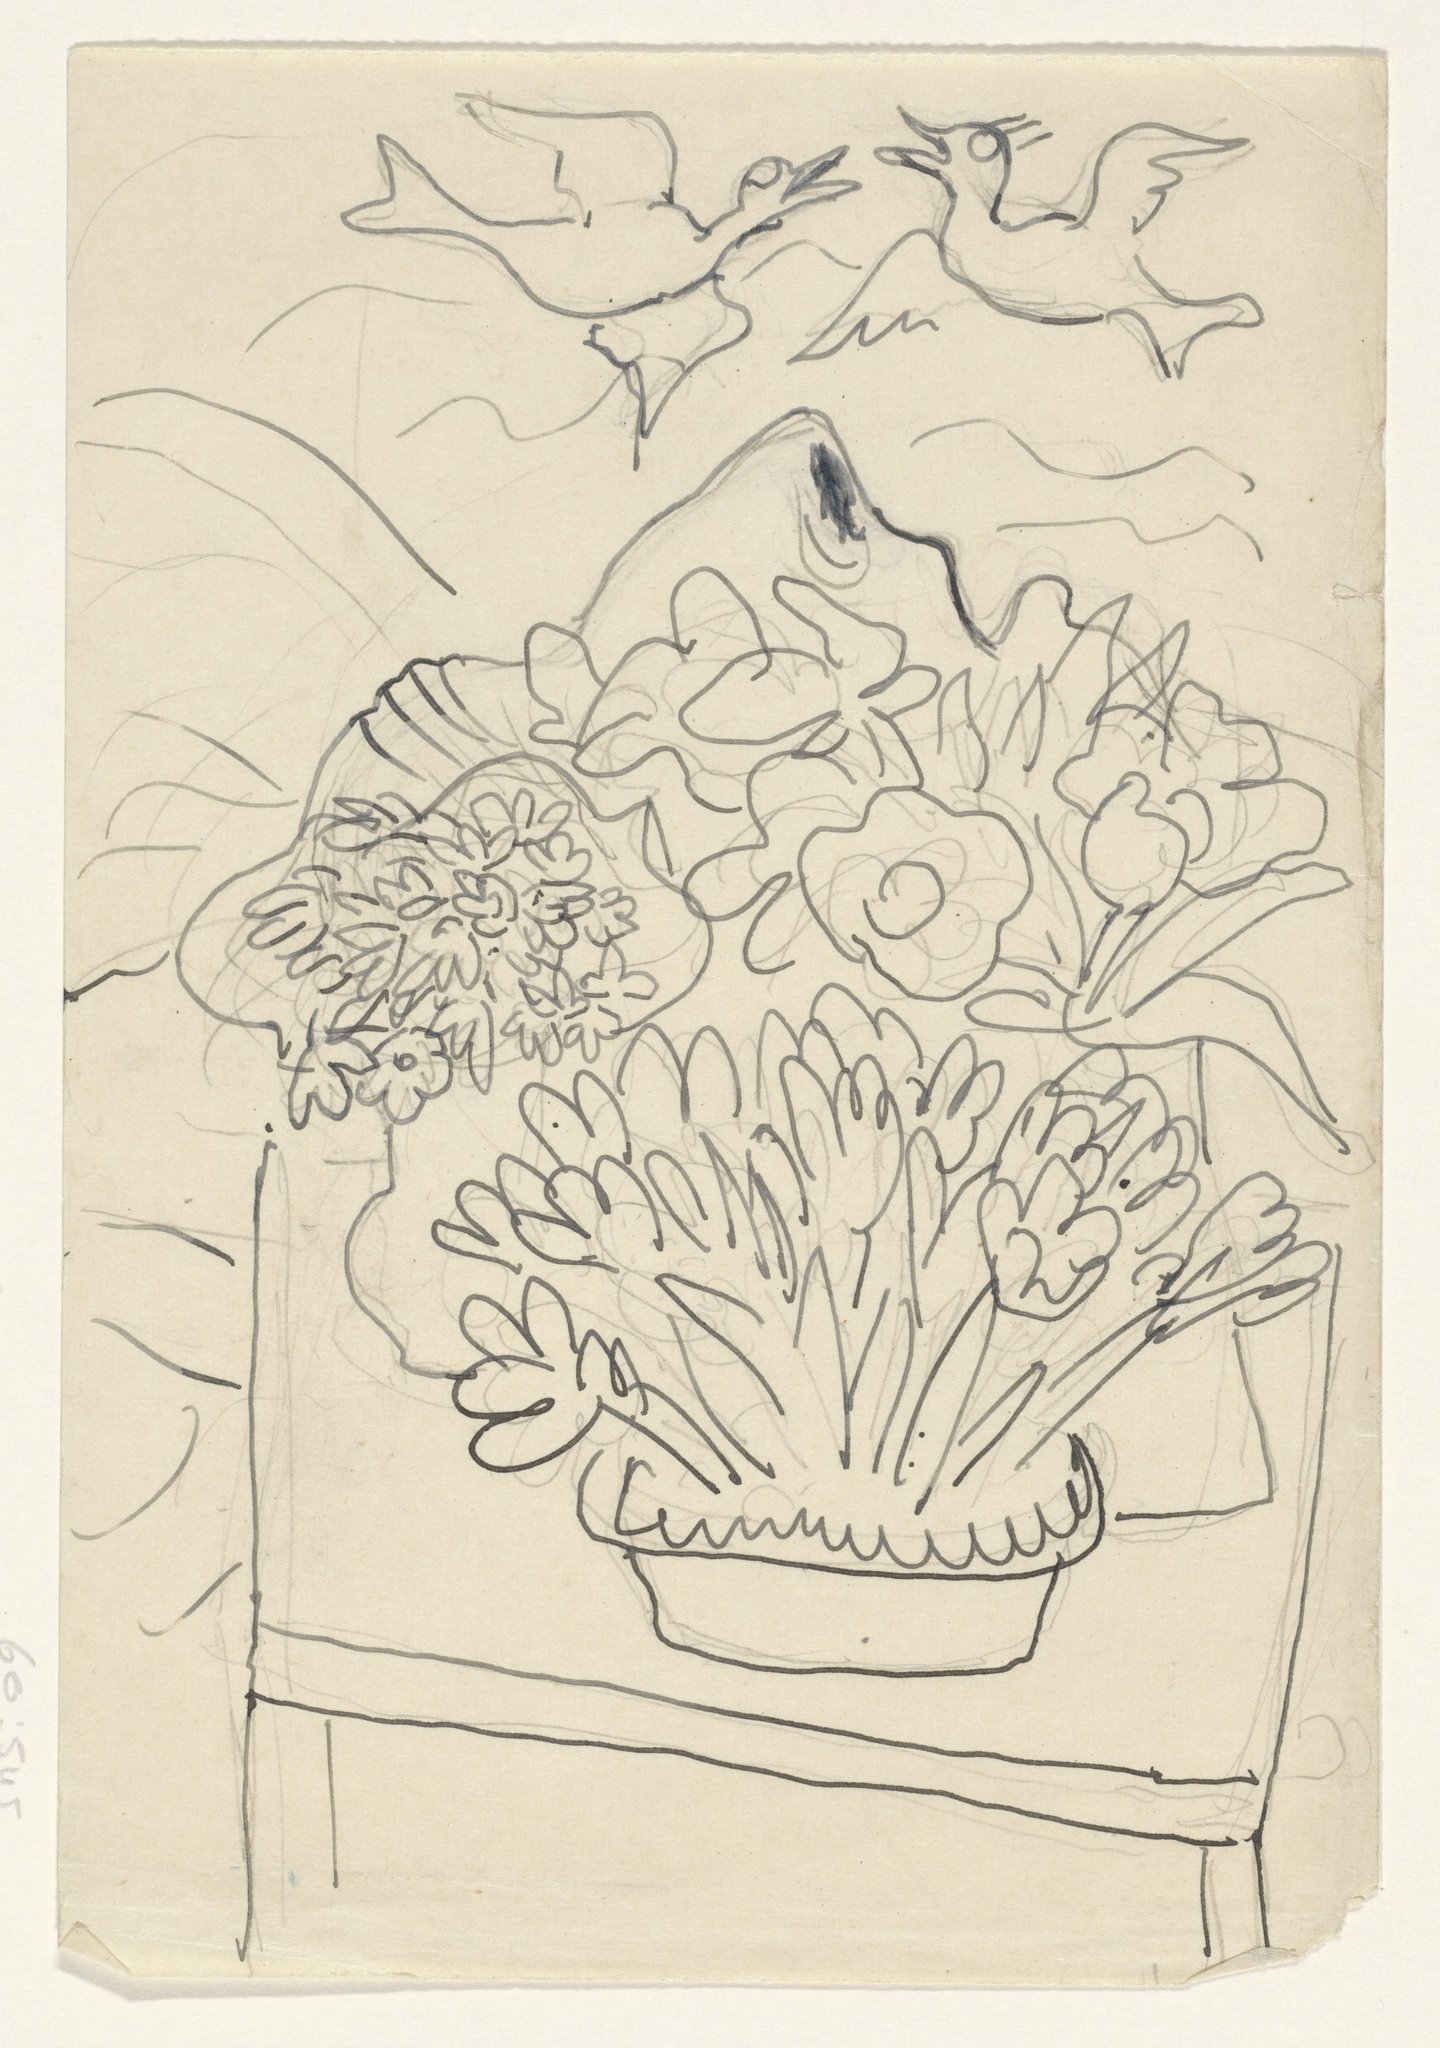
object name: drawing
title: Bloemenvaas op een tafel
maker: leo gestel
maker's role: draughtsman, print maker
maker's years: 1881-1941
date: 1891-1941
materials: ink, paper, pencil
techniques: pen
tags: birds, flowers in a vase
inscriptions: collector's mark